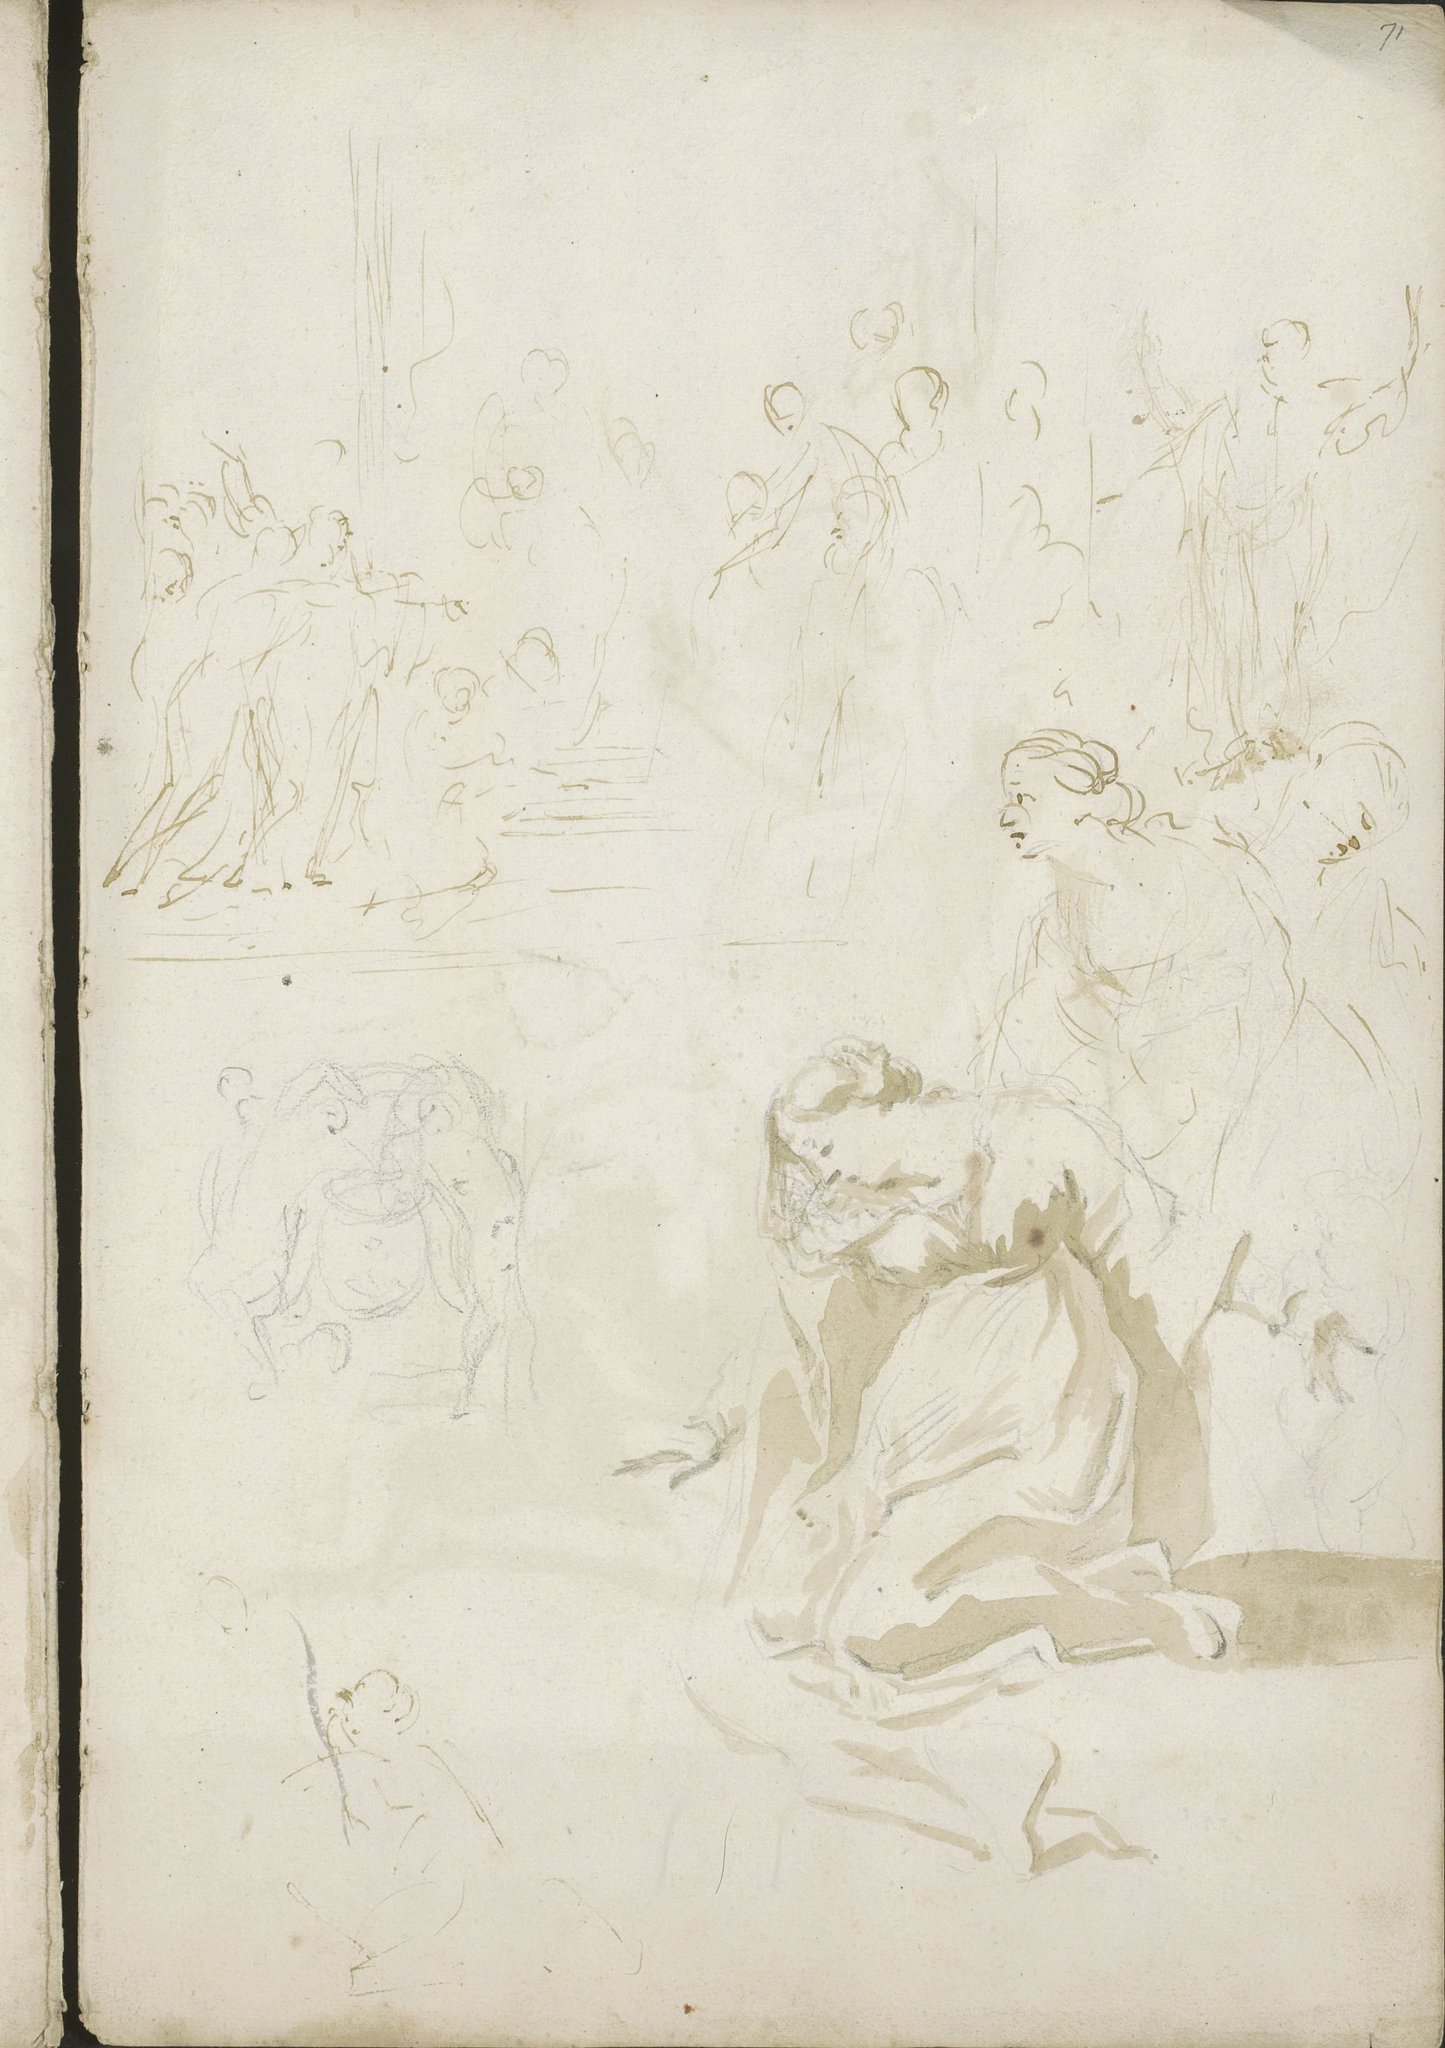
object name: sketchbook leaf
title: Studieblad met compositiestudie en figuren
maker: Anonymous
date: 1650-1799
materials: ink, paper, pencil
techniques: brush, pen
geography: italy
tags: kneeling figure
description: Onder andere een studie van een knielende vrouw. Bladzijde 71 uit een schetsboek met 72 bladzijden.